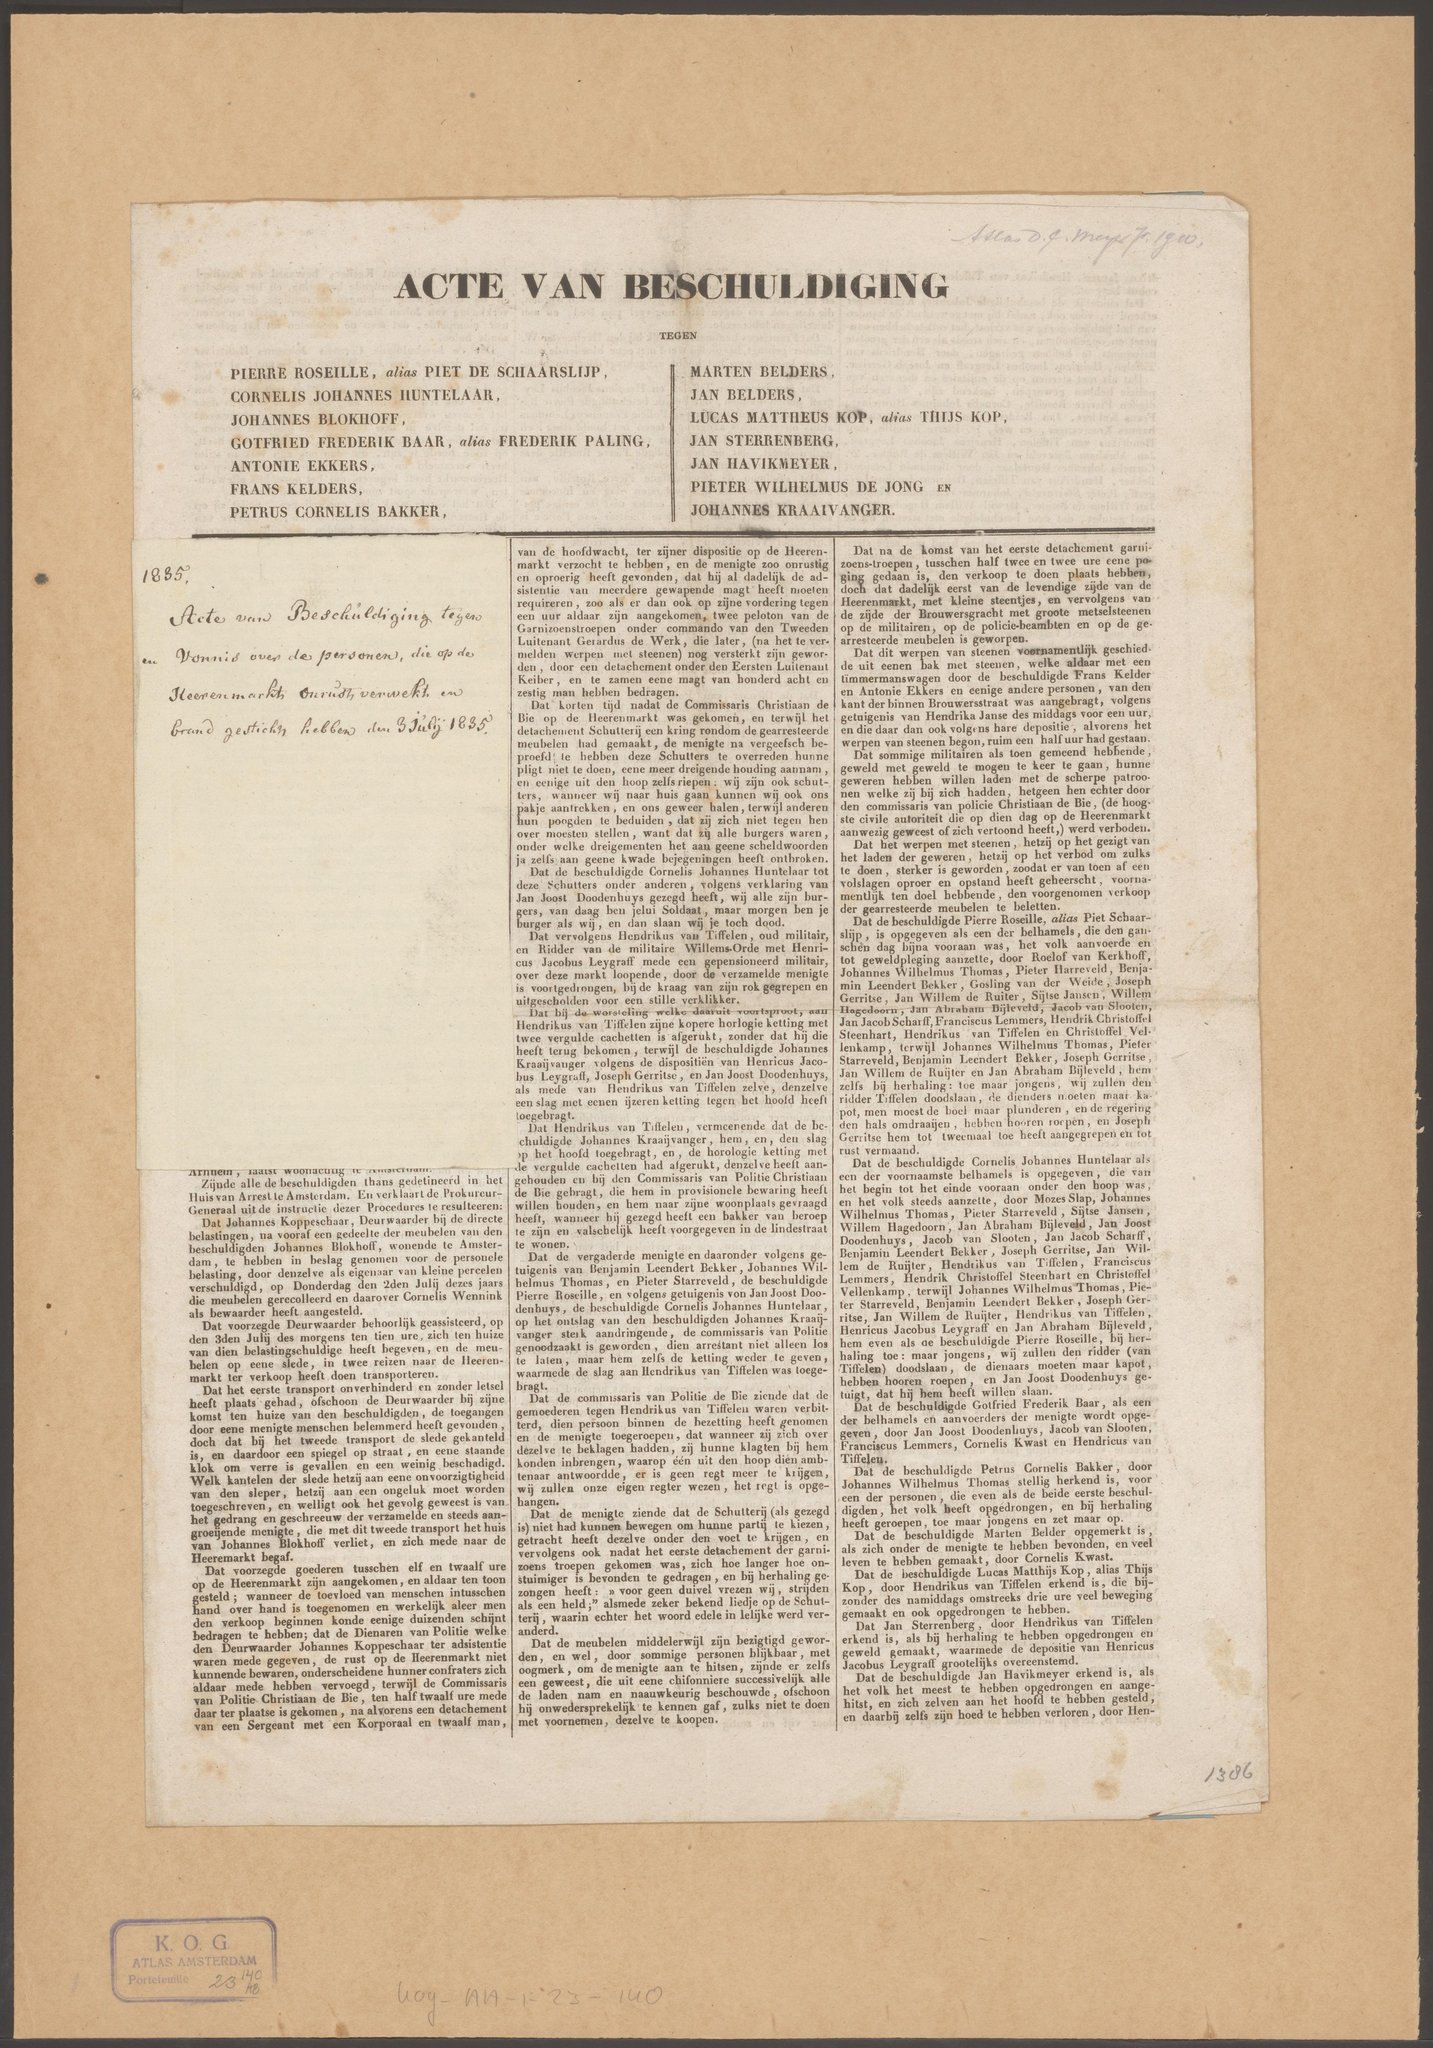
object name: document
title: Acte van beschuldiging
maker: dirk van hogendorp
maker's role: jurist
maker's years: 1797-1845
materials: paper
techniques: letterpress printing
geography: the hague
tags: criminal law; punishment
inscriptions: inscription: ‘1835 / Acte van Beschuldiging tegeno / en Vonnis over de personen, die op de / Heerenmarkt onrust verwekt en / brand gesticht hebben den 3 julij 1835.’, collector's mark: Lugt 1641b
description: Object bestaat uit een bifolium. Onderwerpsrubriek binnen de Atlas Amsterdam: Rechtswezen.